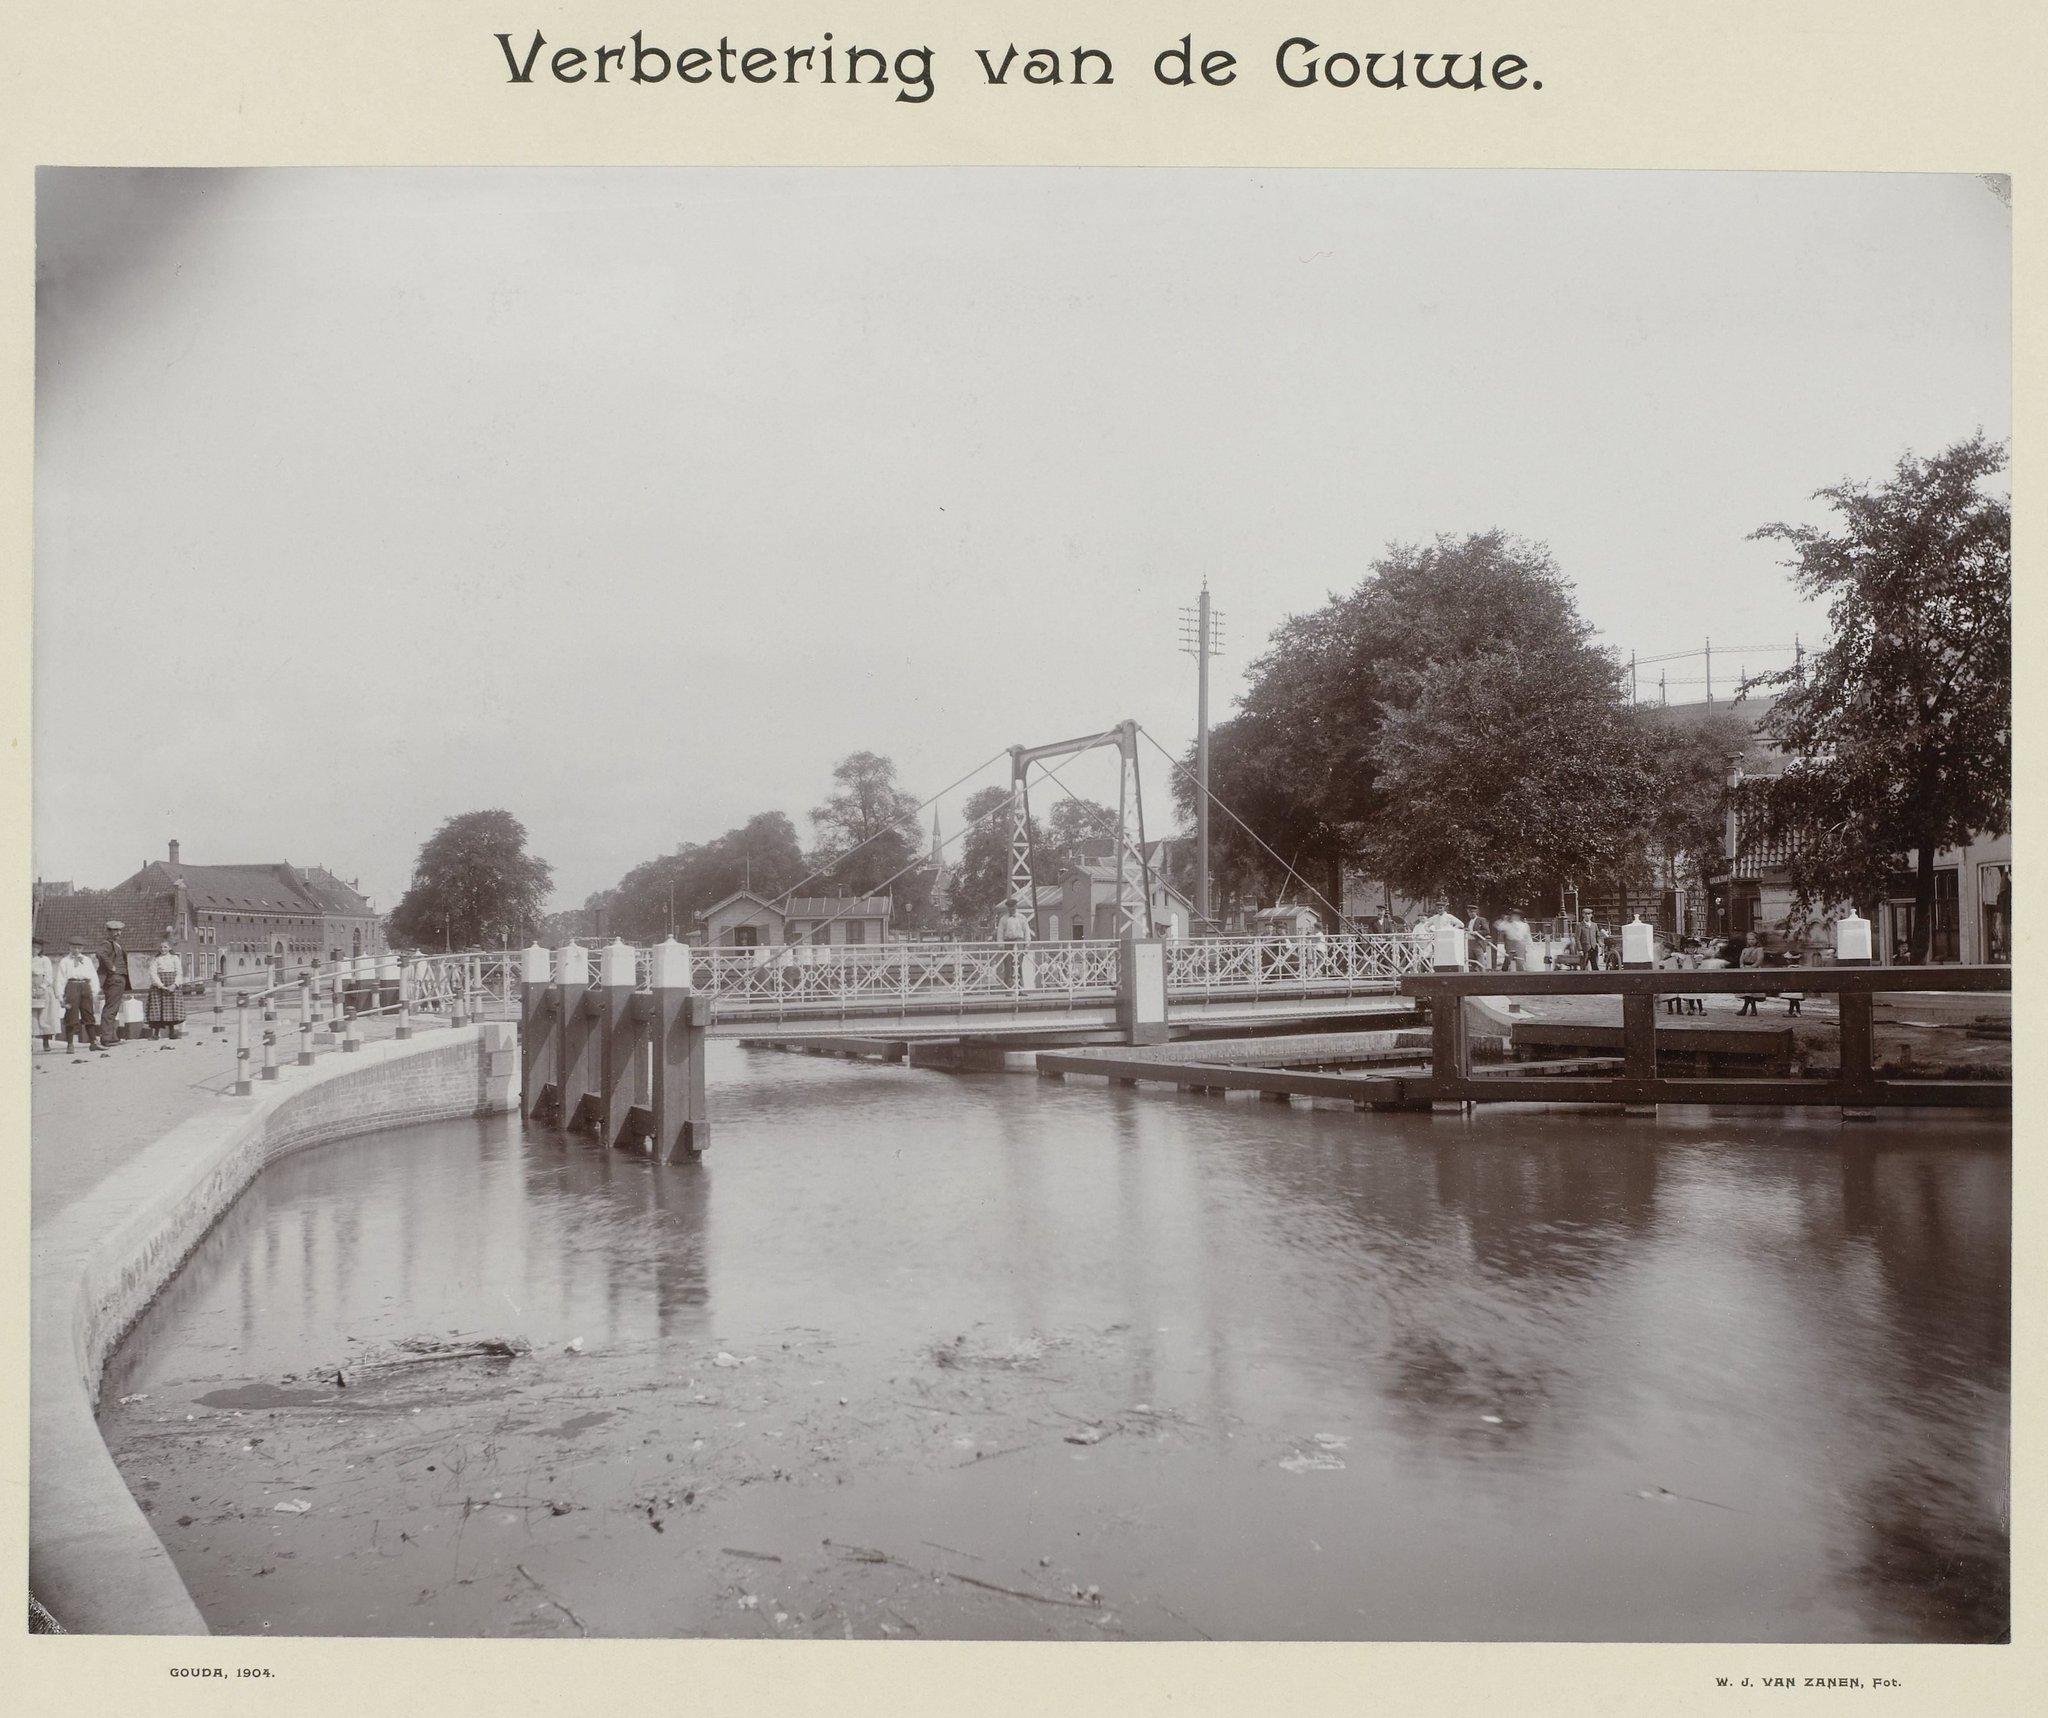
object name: photograph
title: Verbetering van de Gouwe.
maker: weijert jan van zanen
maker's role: fotograaf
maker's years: 1873-1960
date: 1904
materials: cardboard, paper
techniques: photography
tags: gouda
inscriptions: date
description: Foto op karton van waterbouwkundige werken (verbeteringen die in 1904 aan de Gouwe te Gouda zijn aangebracht). Gedateeerd en gesigneerd.